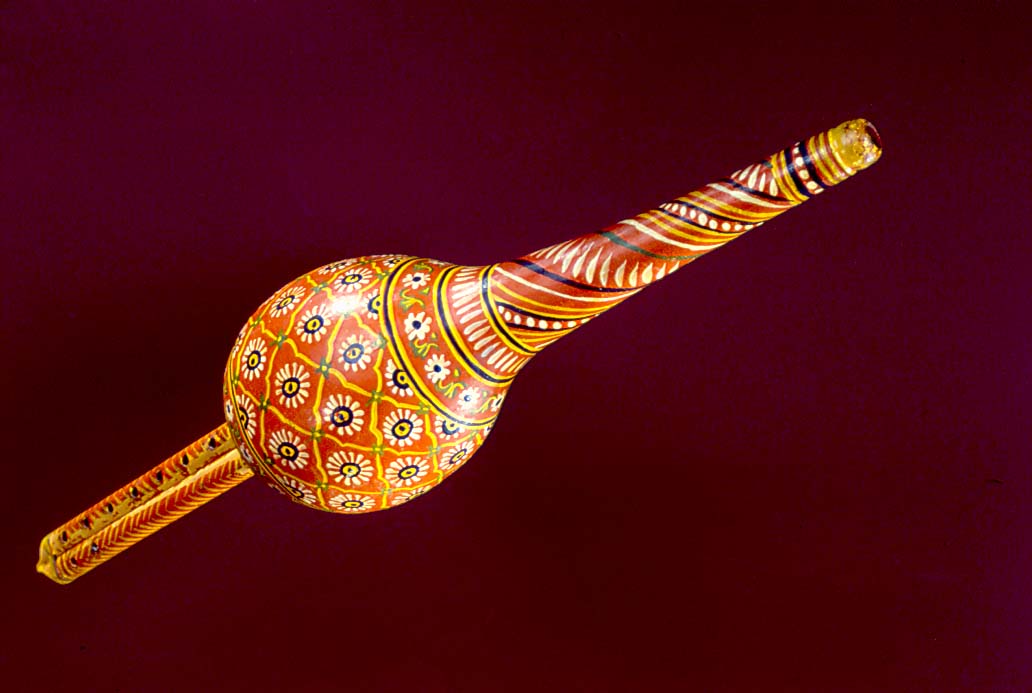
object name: pūngī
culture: indian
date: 1867-1900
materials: paint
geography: india